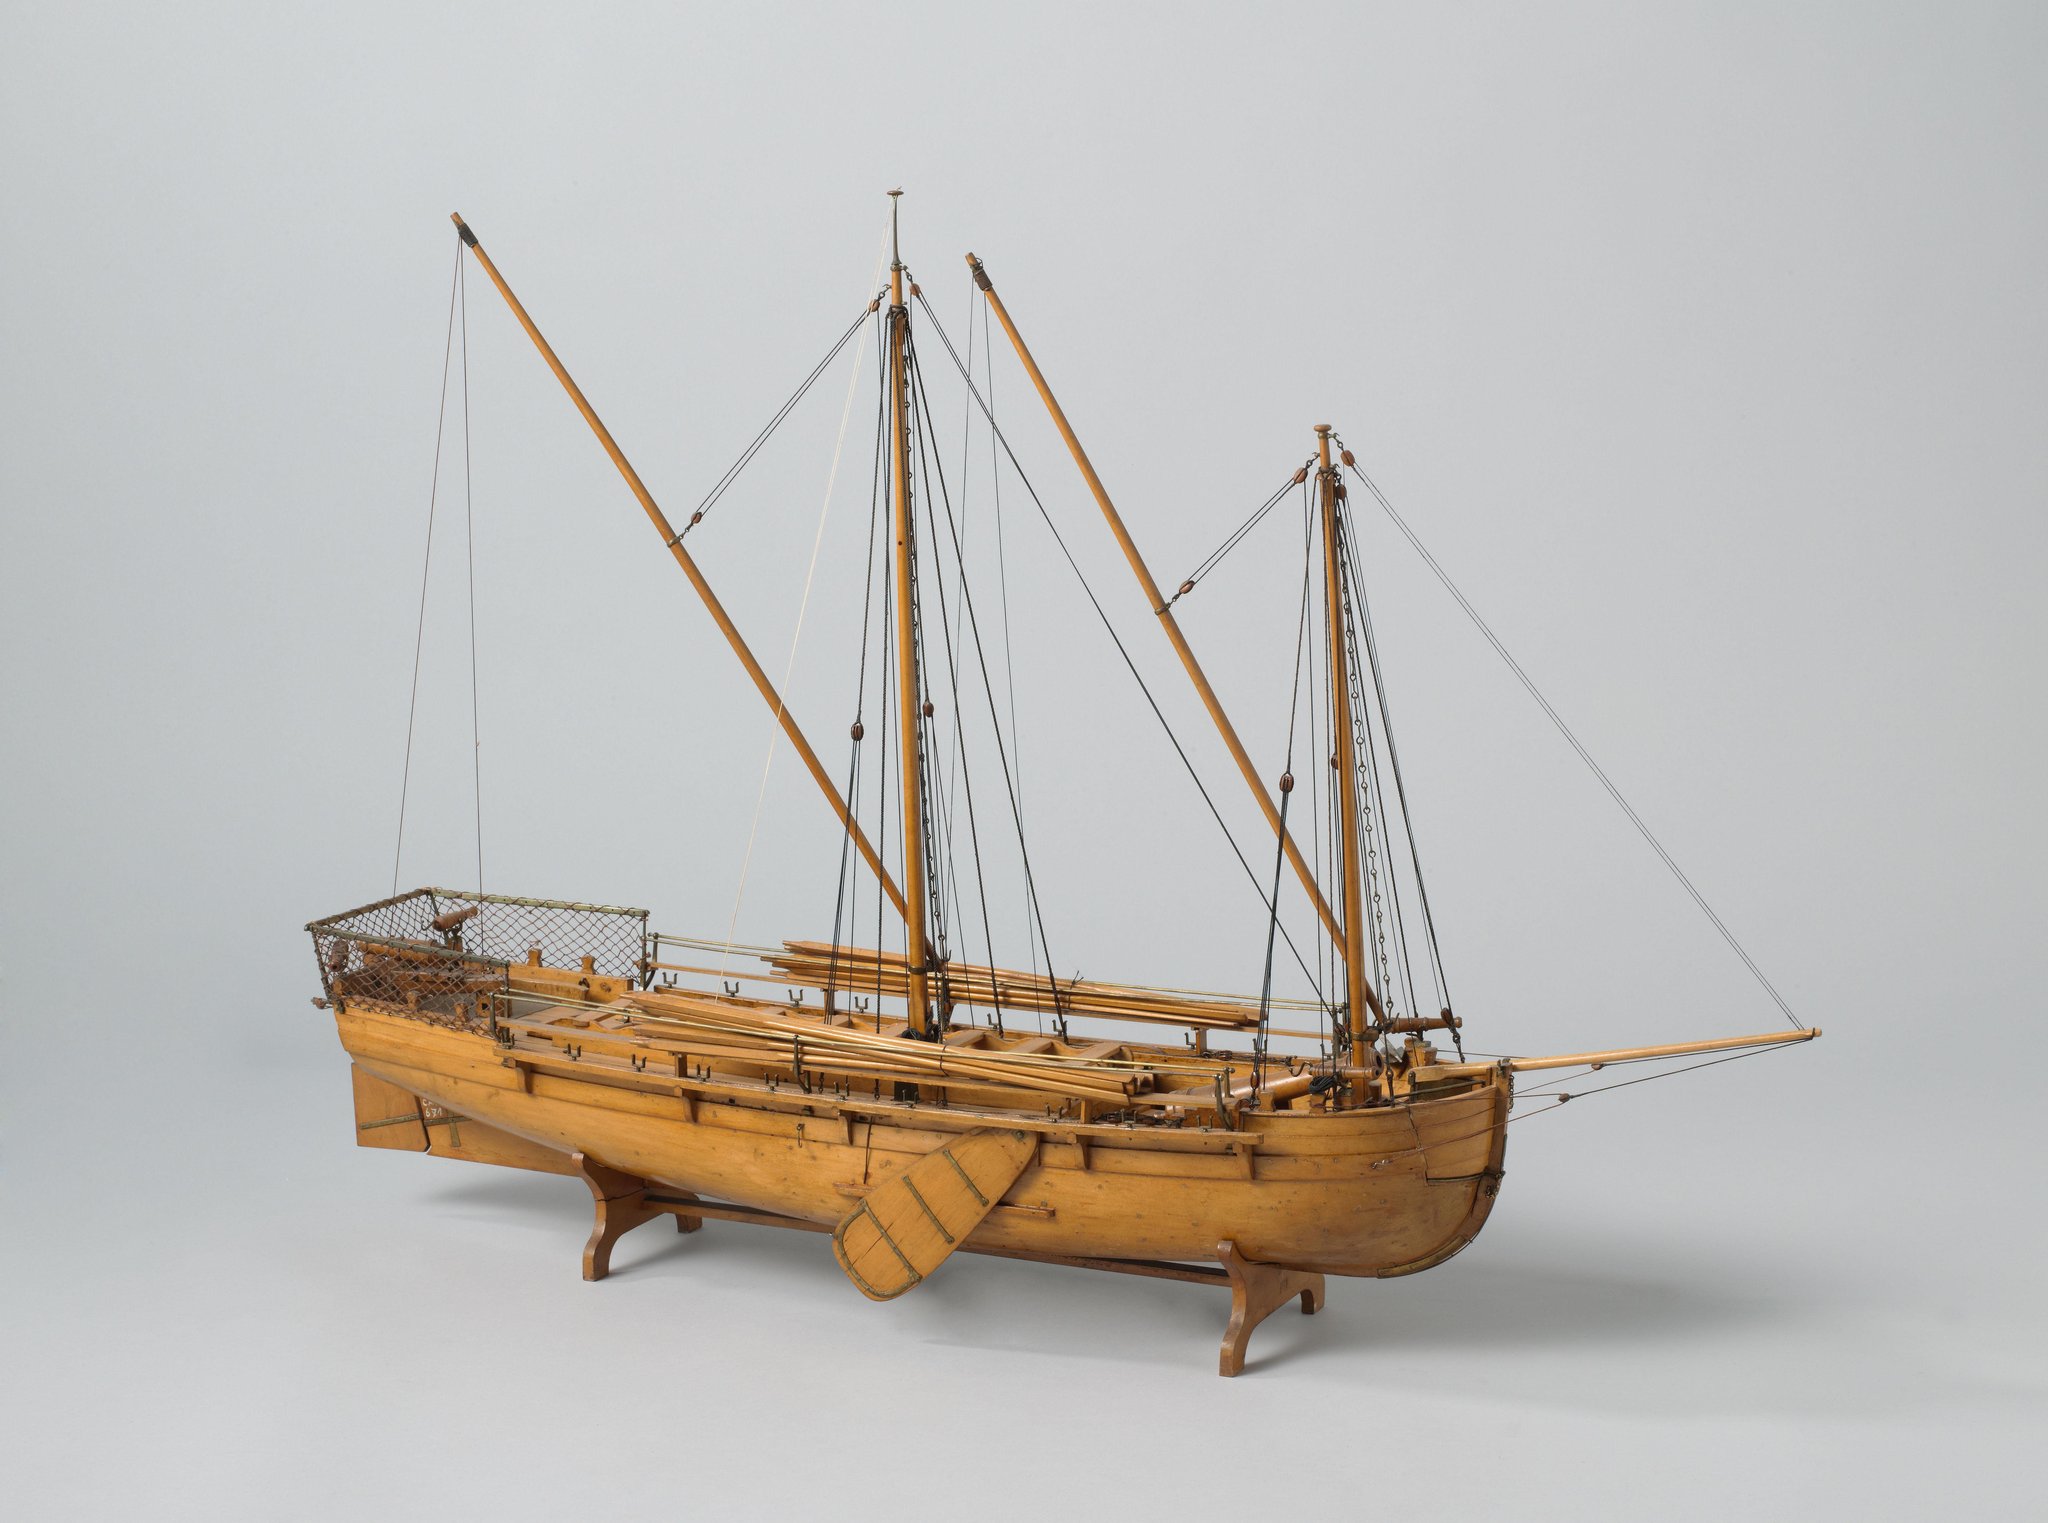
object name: ship model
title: Model of a Gunboat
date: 1830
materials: brass, glass, iron, fiber, wood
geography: denmark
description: Dit type kanonneerboot, lang 14.15 m, werd in Denemarken ontwikkeld en in 1830 in de Nederlandse Marine in gebruik genomen. In de jaren 1830-1833 deed een aantal van deze schepen dienst op de bovenrivieren bij Nijmegen, Grave en 's-Hertogenbosch, maar zij voldeden niet: het tuig was onhandelbaar, met roeien kon niet genoeg snelheid gemaakt worden, er was niet genoeg ruimte voor de bemanning en het risico water te maken door de boegpoort was te groot.